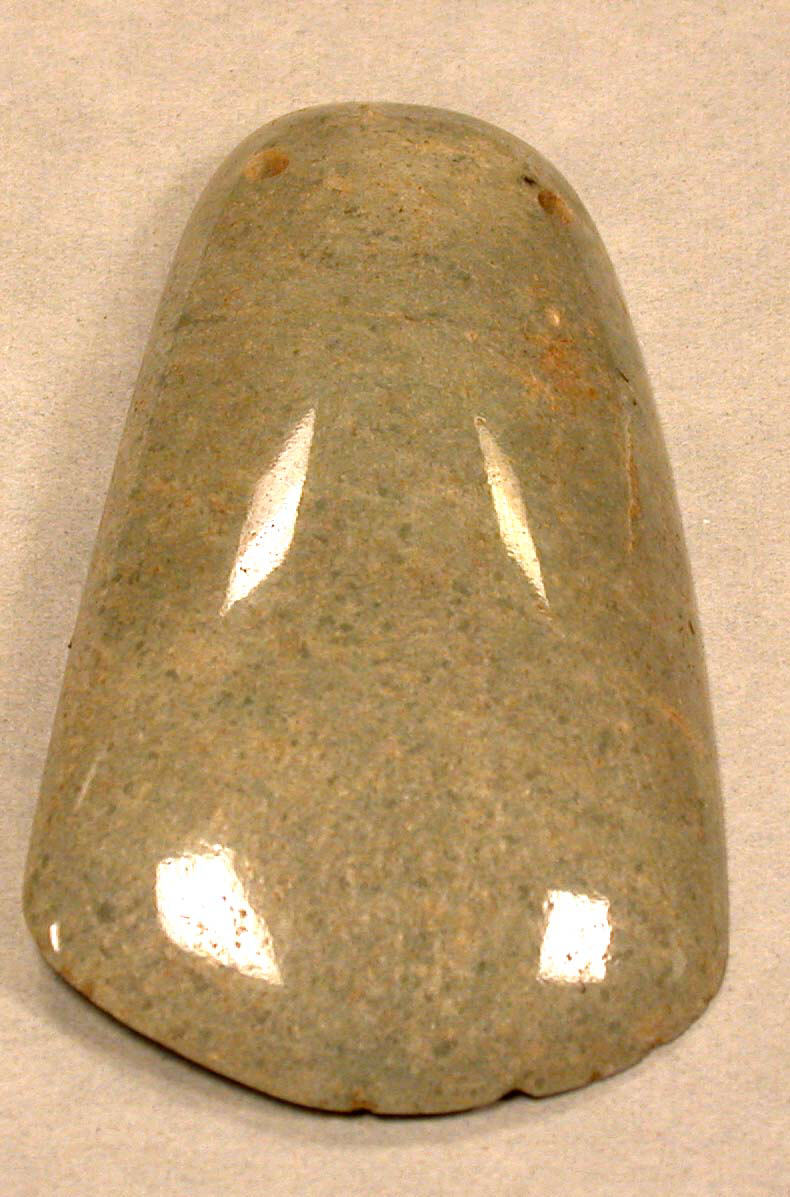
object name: pendant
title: Celt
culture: costa rican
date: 1501-1600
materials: stone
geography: costa rica